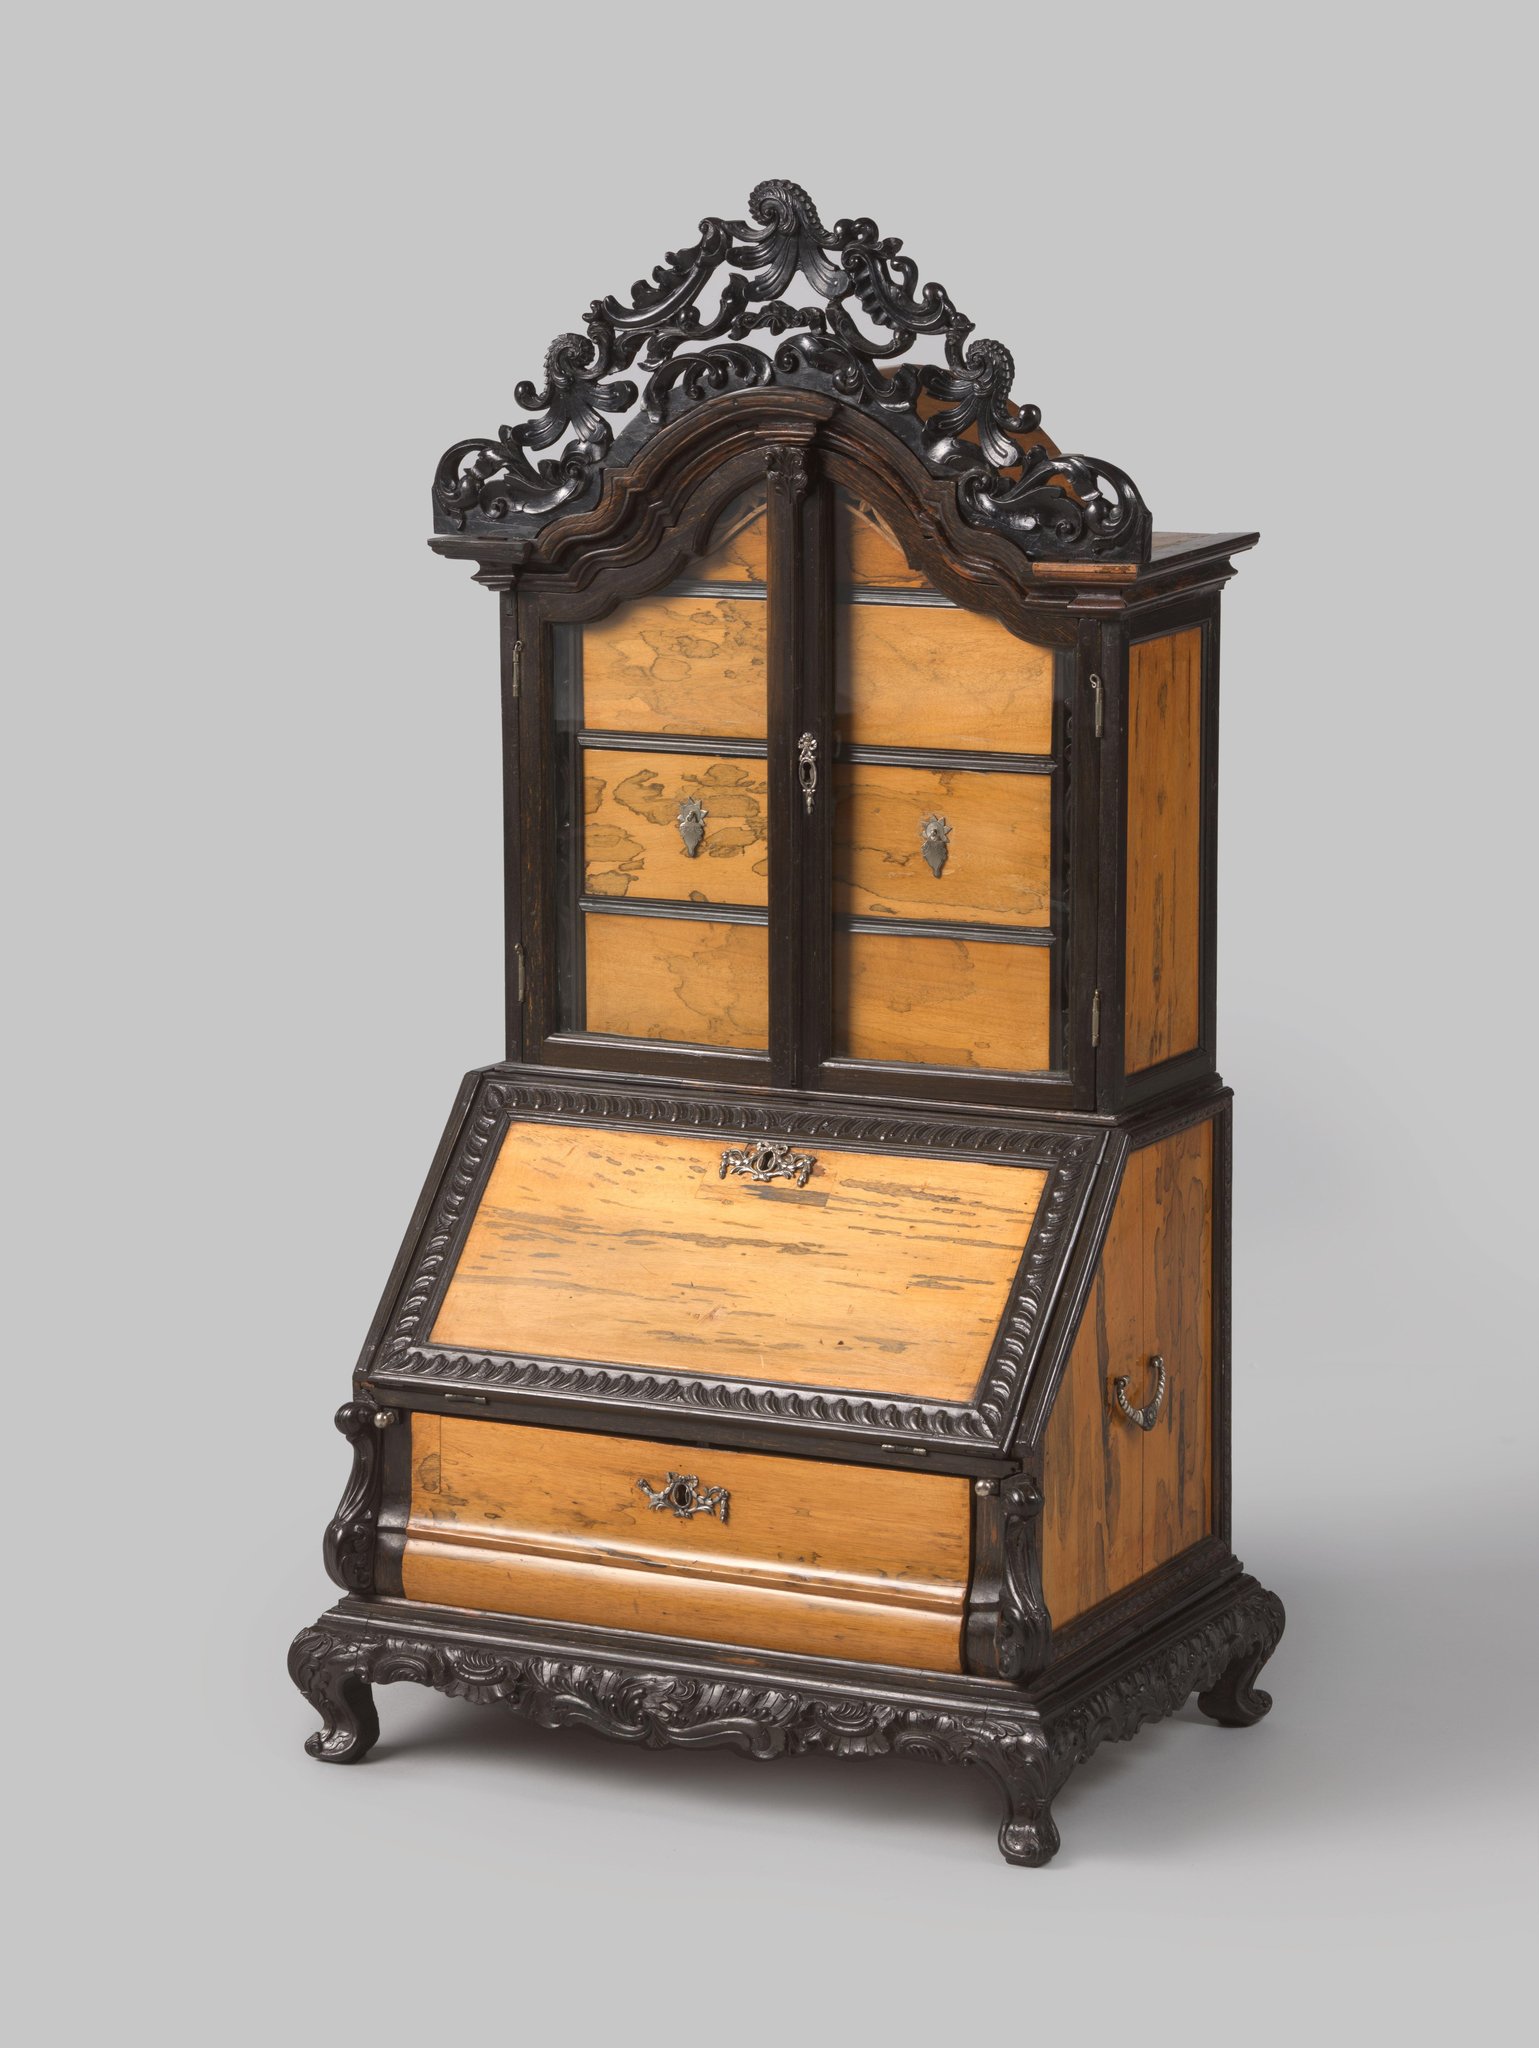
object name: bureau table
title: Opstand met twee deuren met glazen ruiten waarachter laden, horend bij bureau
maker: Anonymous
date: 1750-1800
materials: wood, glass, silver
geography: dutch east indies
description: Onderdeel van een bureau, miniatuur met opstand van ebbenhout en het spint van tropisch hout. De opstand met twee deuren met glas, waarachter laden met zilverbeslag en gebeeldhouwd opzetstuk.